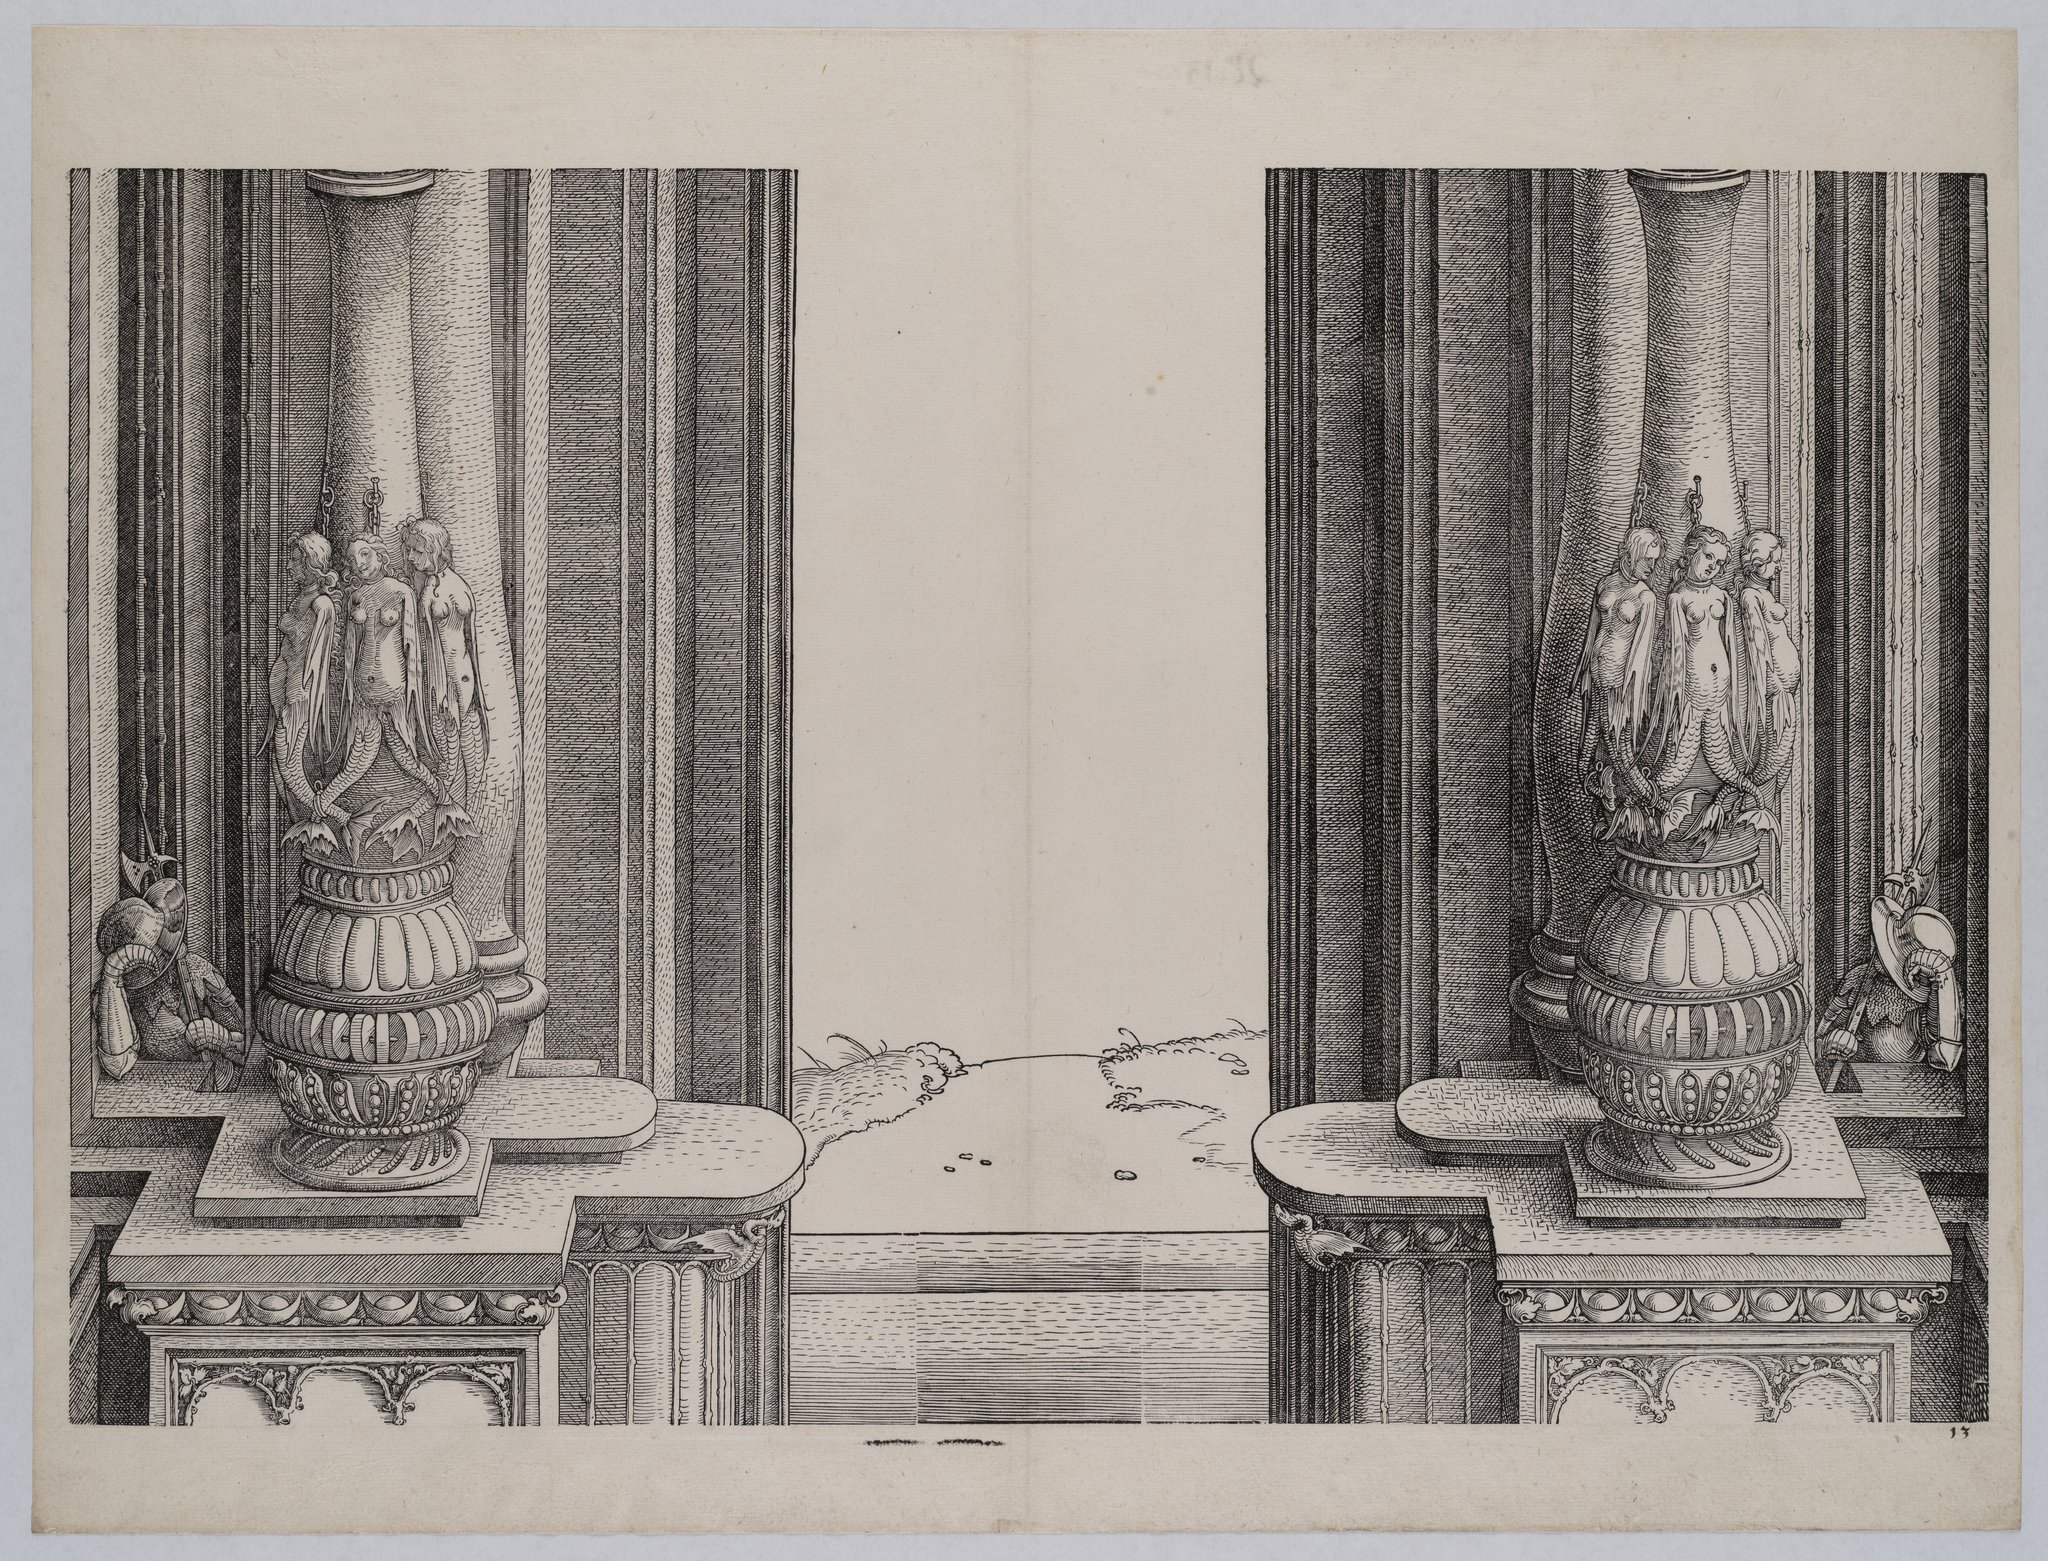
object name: print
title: The Middle Section of the Entryway to the Central Portal, the Columns Decorated by Sirens and Sleeping Soldiers Behind, from the Arch of Honor, proof, dated 1515, printed 1517-18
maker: albrecht dürer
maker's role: artist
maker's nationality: german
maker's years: 1471-1528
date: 1515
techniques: woodcut